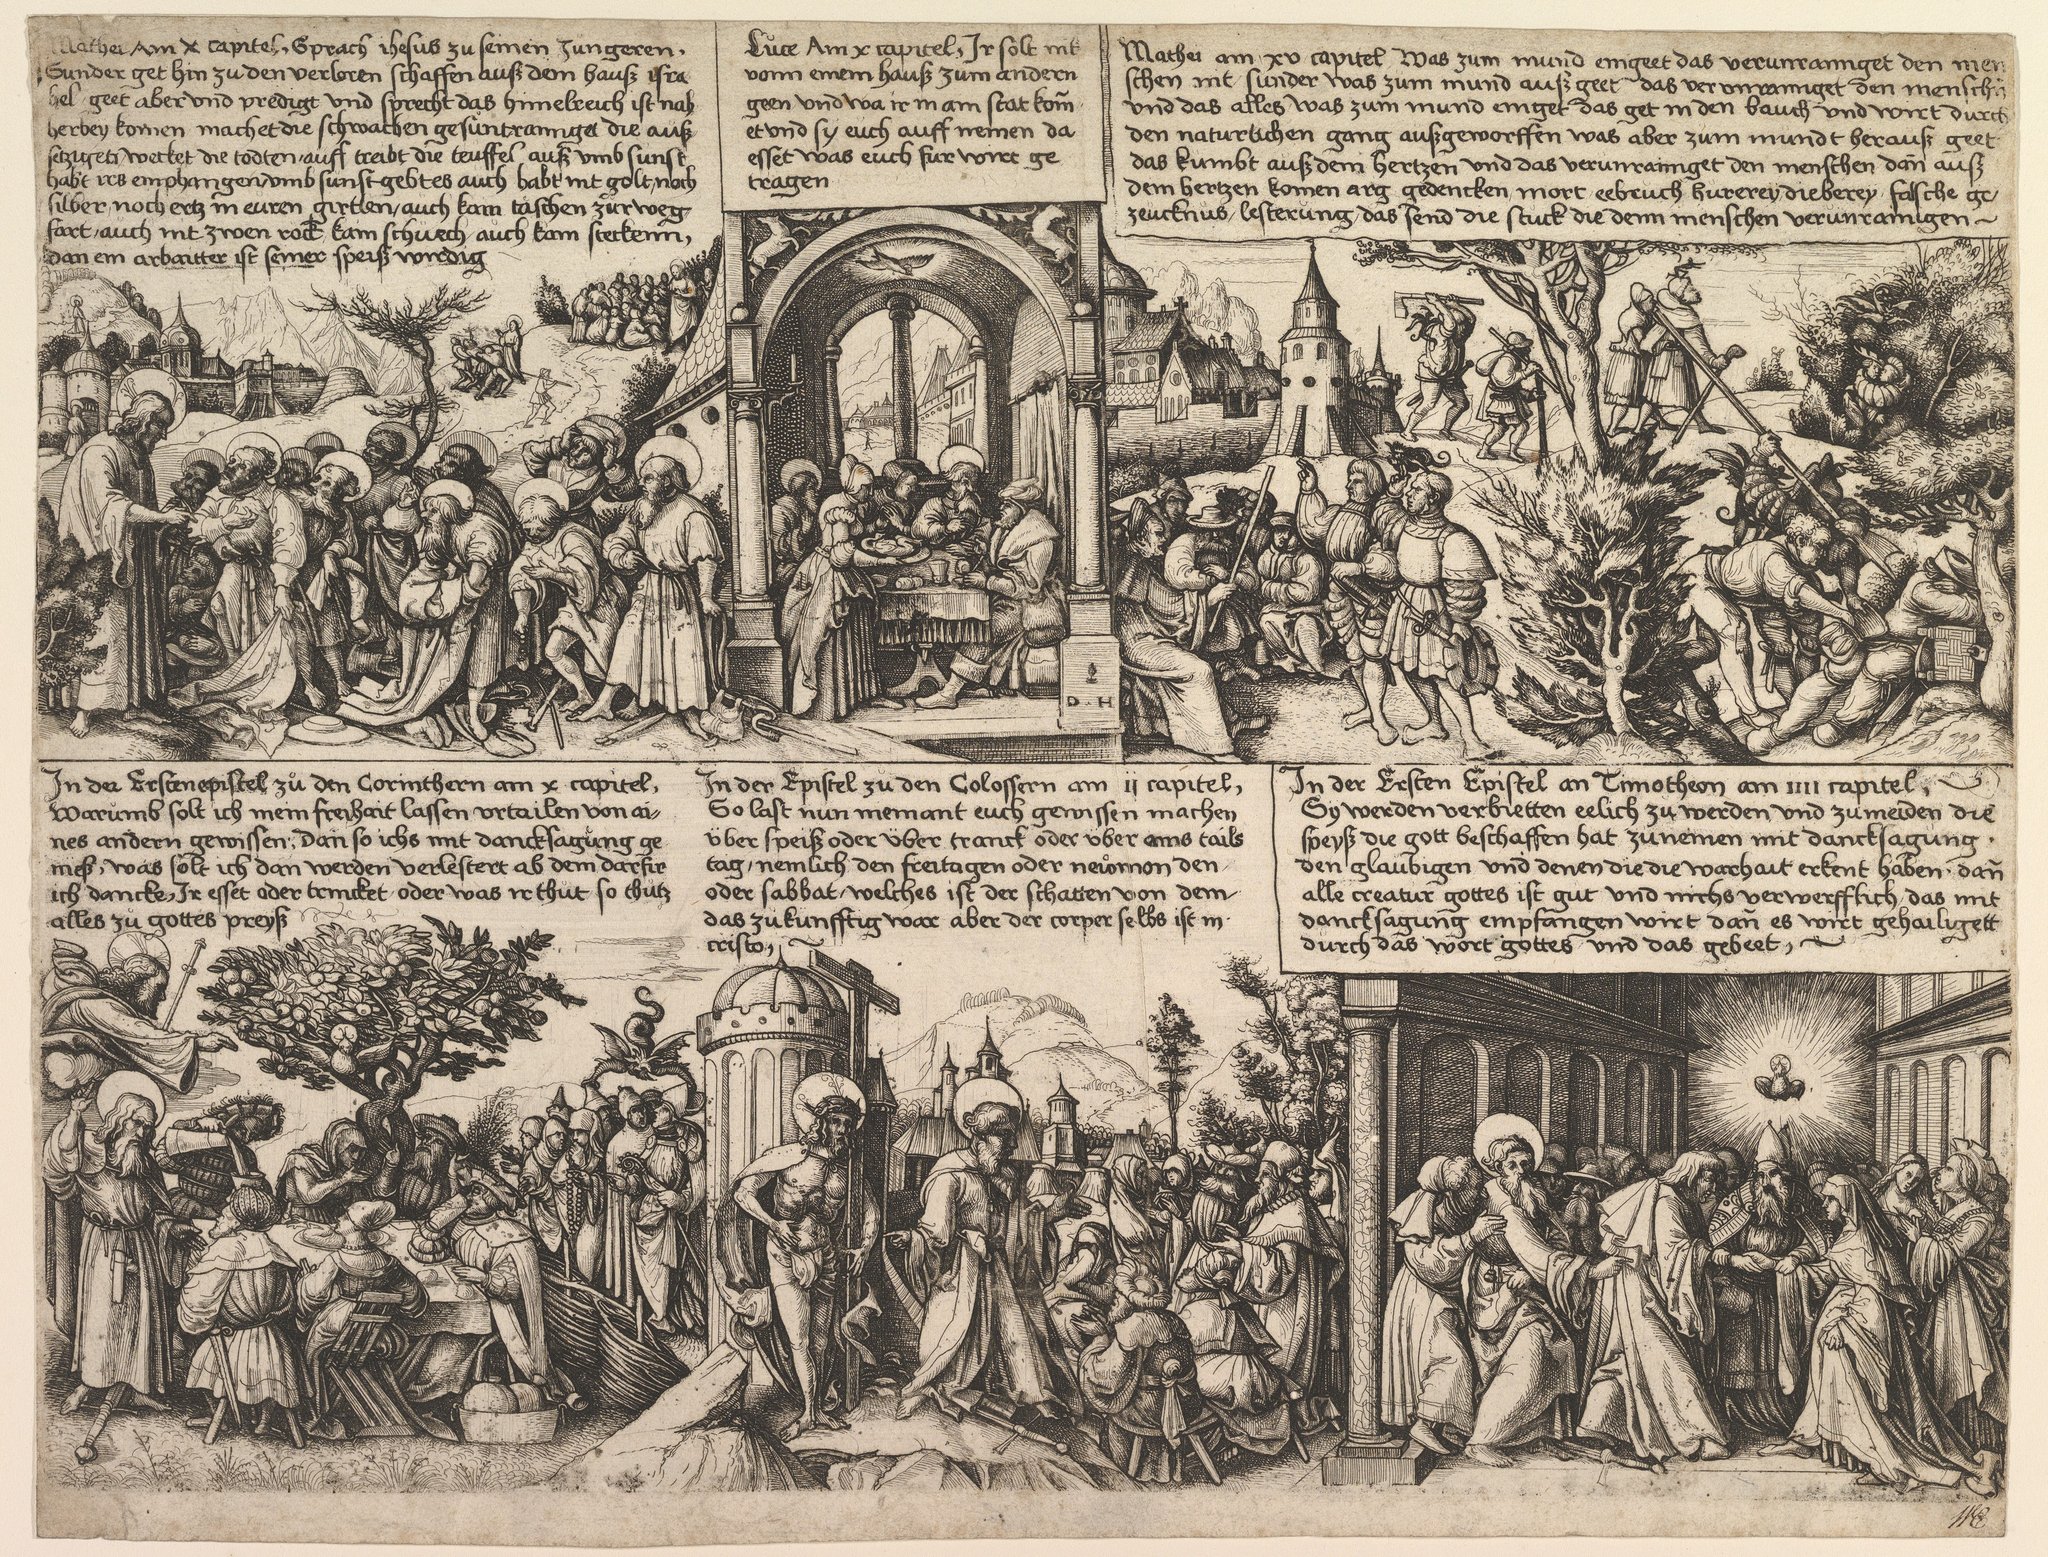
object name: print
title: Different Scenes, from the Gospels and from Acta Apostolorum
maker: daniel hopfer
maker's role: artist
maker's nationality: german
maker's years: 1470-1536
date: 1530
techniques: etching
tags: cross,jesus